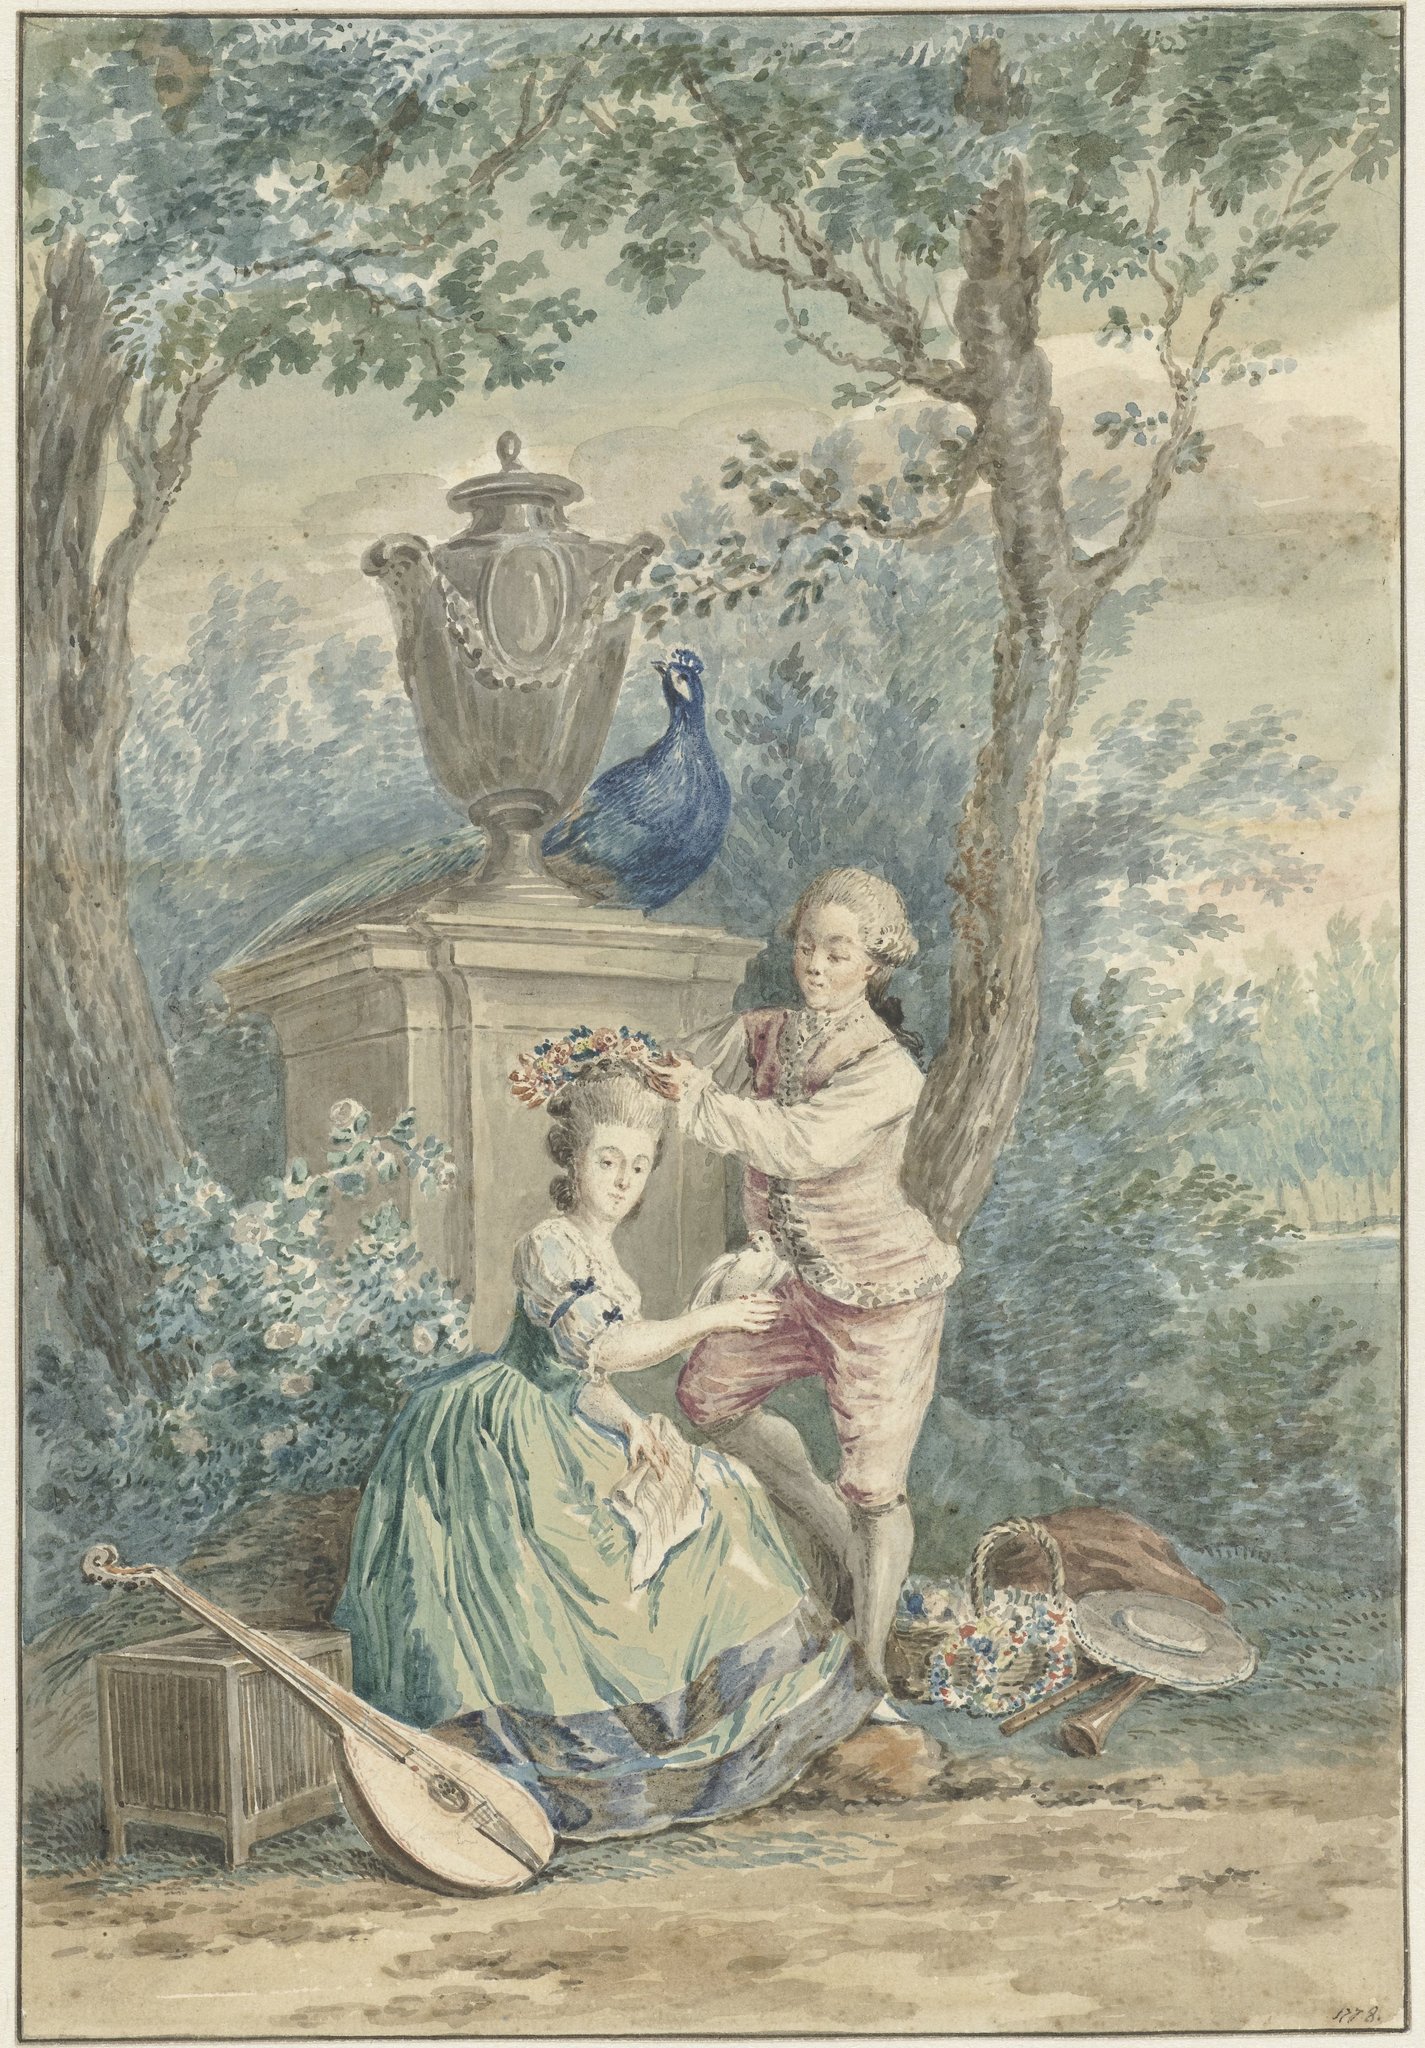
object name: watercolor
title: Elegant paar in een park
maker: nicolaes muys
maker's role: draughtsman, painter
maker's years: 1740-1808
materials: paper, watercolor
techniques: brush